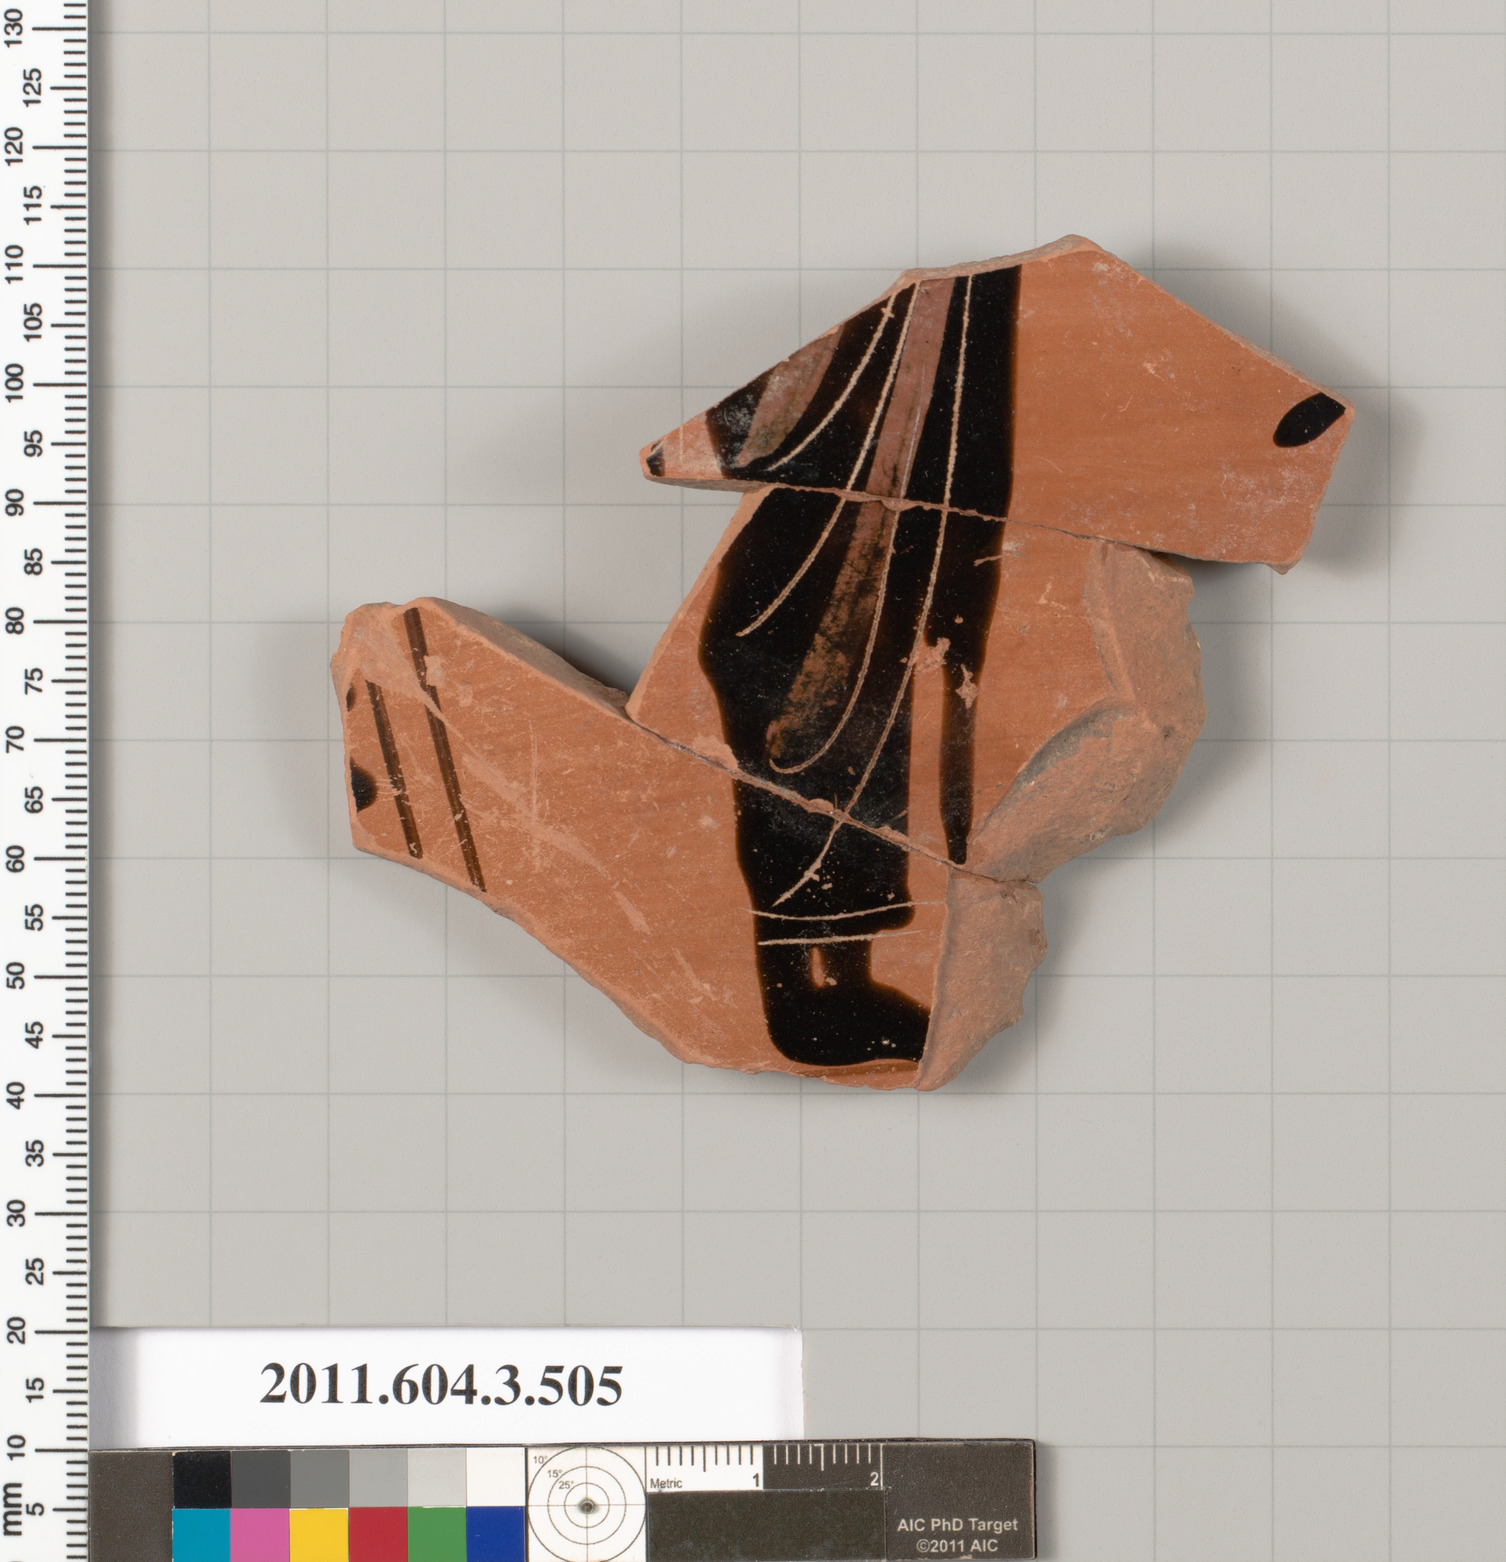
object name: column krater fragment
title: Terracotta fragment of a column-krater (bowl for mixing wine and water)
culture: greek, attic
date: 525-501 BCE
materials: terracotta